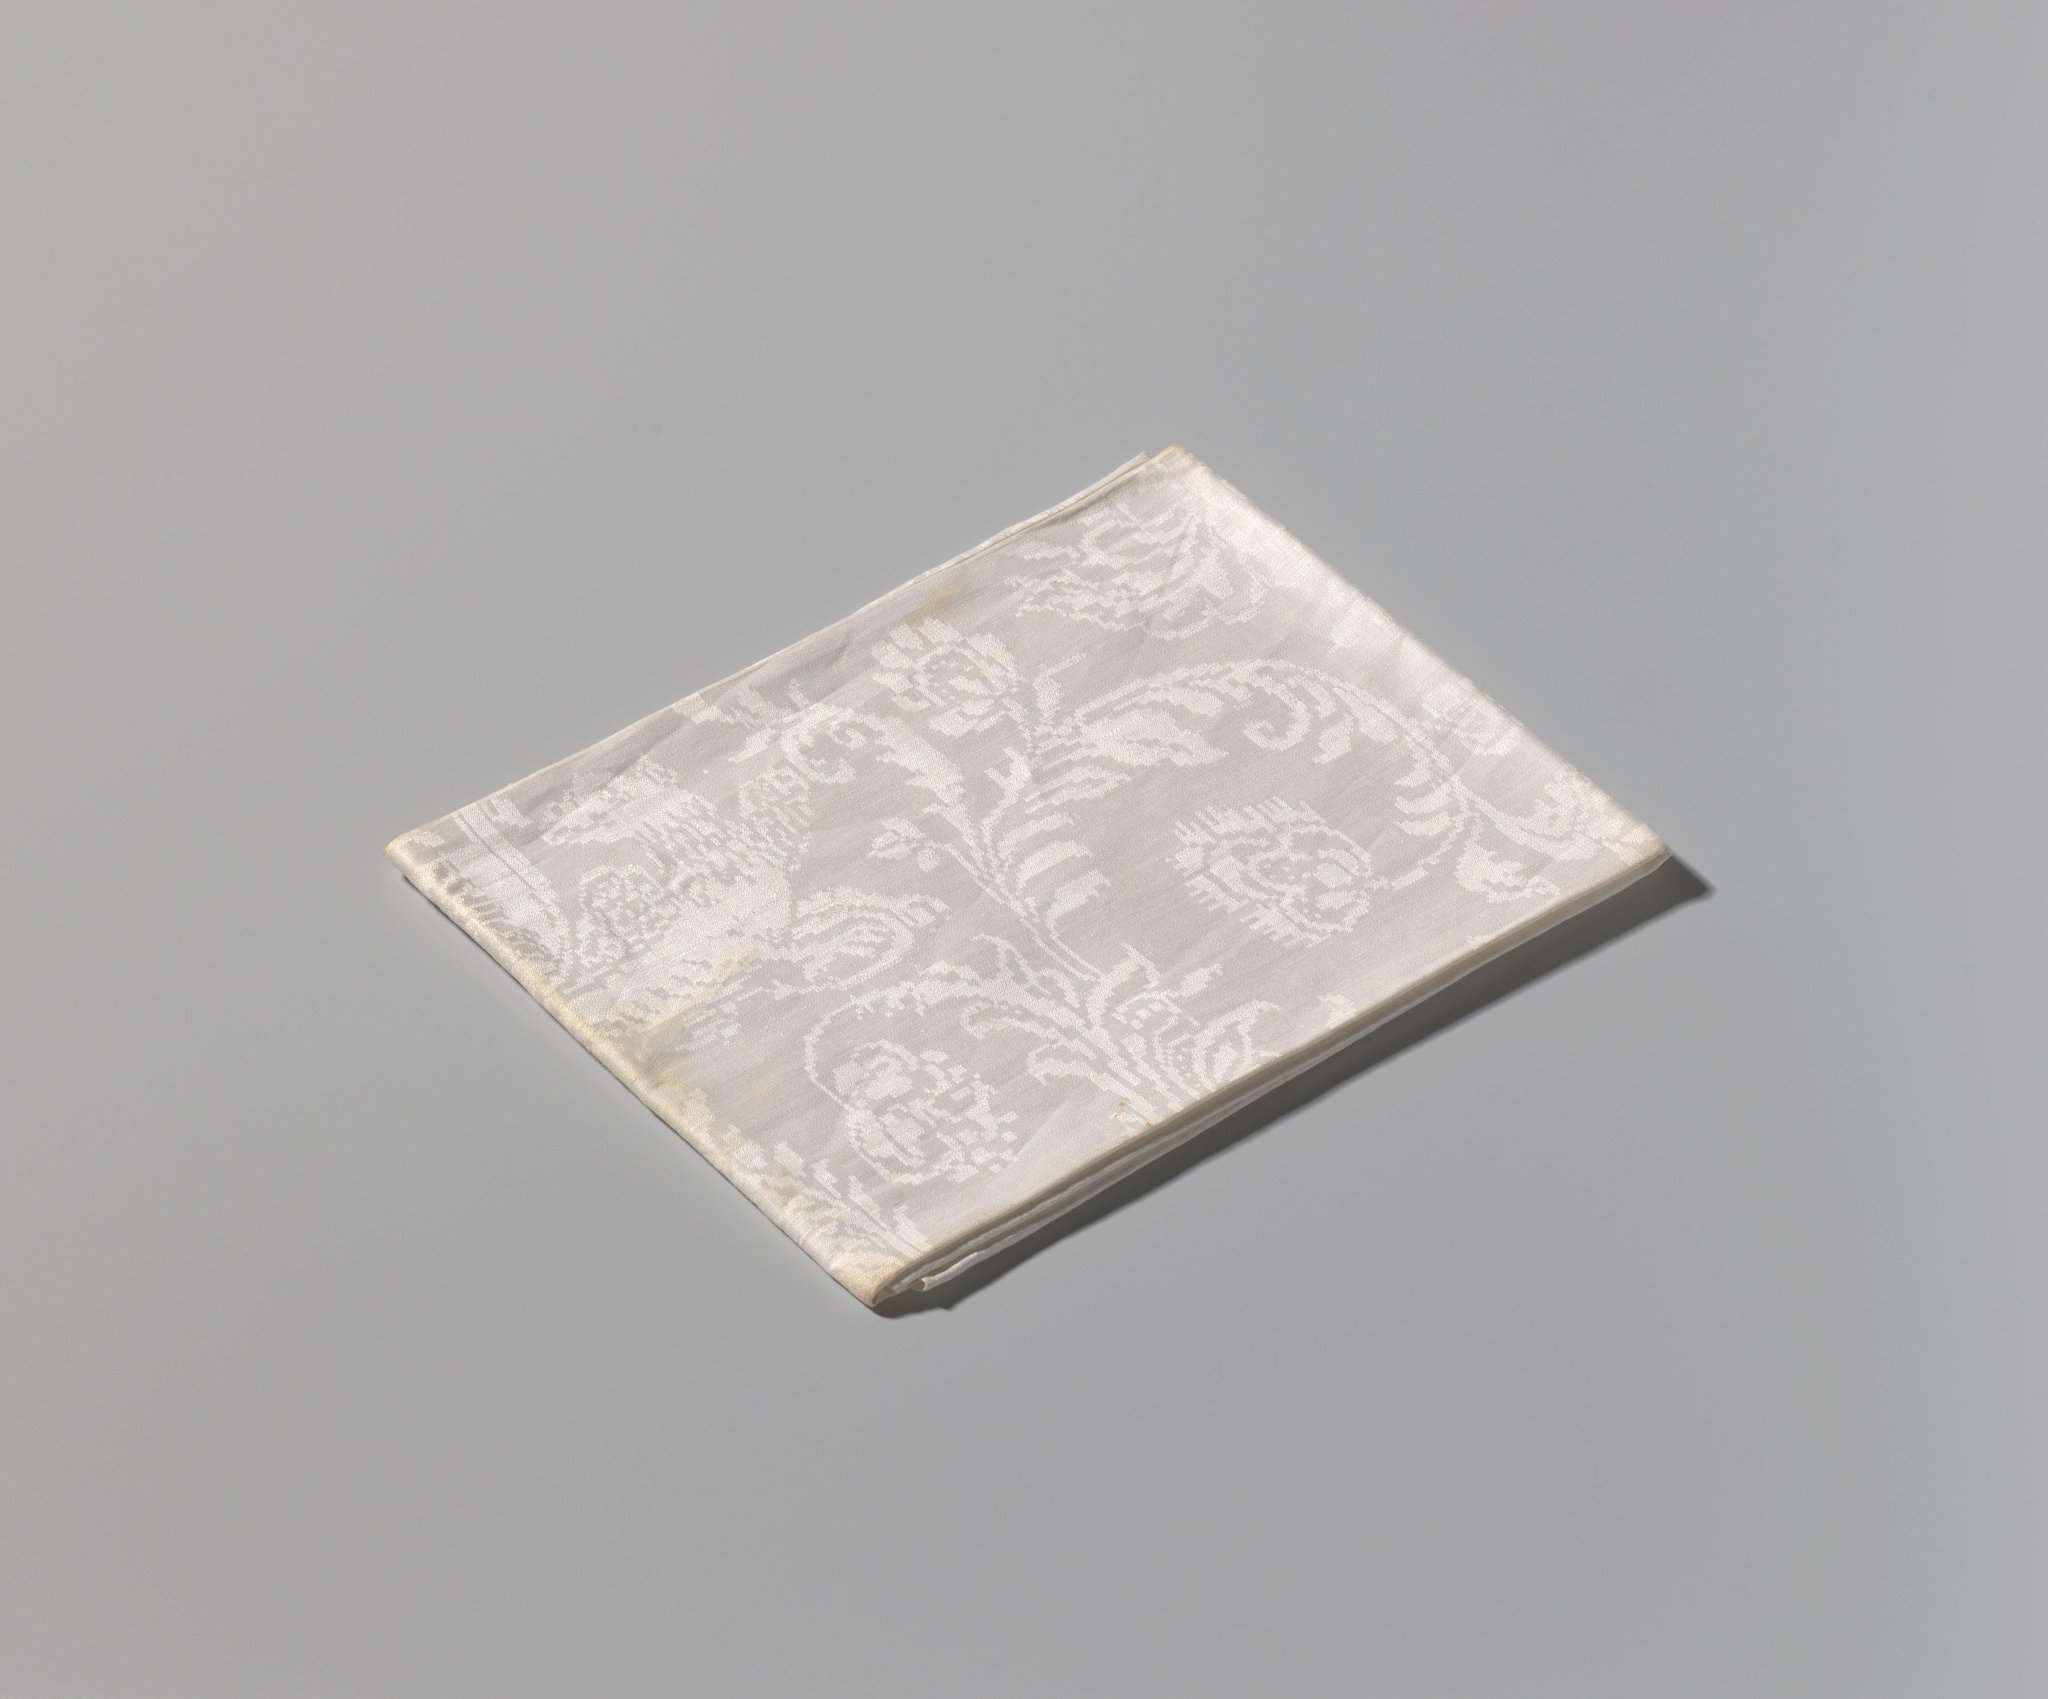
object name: napkin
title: Servet met het wapen van Cornelis Hop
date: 1700-1724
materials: linen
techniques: damask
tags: amsterdam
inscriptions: mark: ‘H’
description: Servet van linnendamast met het wapen van Cornelis Hop. Middenveld: symmetrische patroon van veelsoortige voluutranken met op de knooppunten geblokte verdikkingen. Daartussen een liggend ovaal schild met een wapen van Cornelis Hop (1685-1762), ambassadeur aan het hof van koning Lodewijk XV van Frankrijk: gevierendeeld, 1 en 4 kopvogel staande op bol (de vogel van 1 omgewend, die van 4 omziend); 2 en drie twee afgewende vleugels. Hartschild gedeeld: 1 een dwarsbalk, 2 rechts een vijfpuntige ster, links een gewende wassenaar. Het schild gedekt met vijfbladerige kroon. Schildhouders: rechts een afgewende adelaar, links een afgewende leeuw. Randen: wapentrofeeën. Hoeken: een rondas. Rondom blokkenrand.